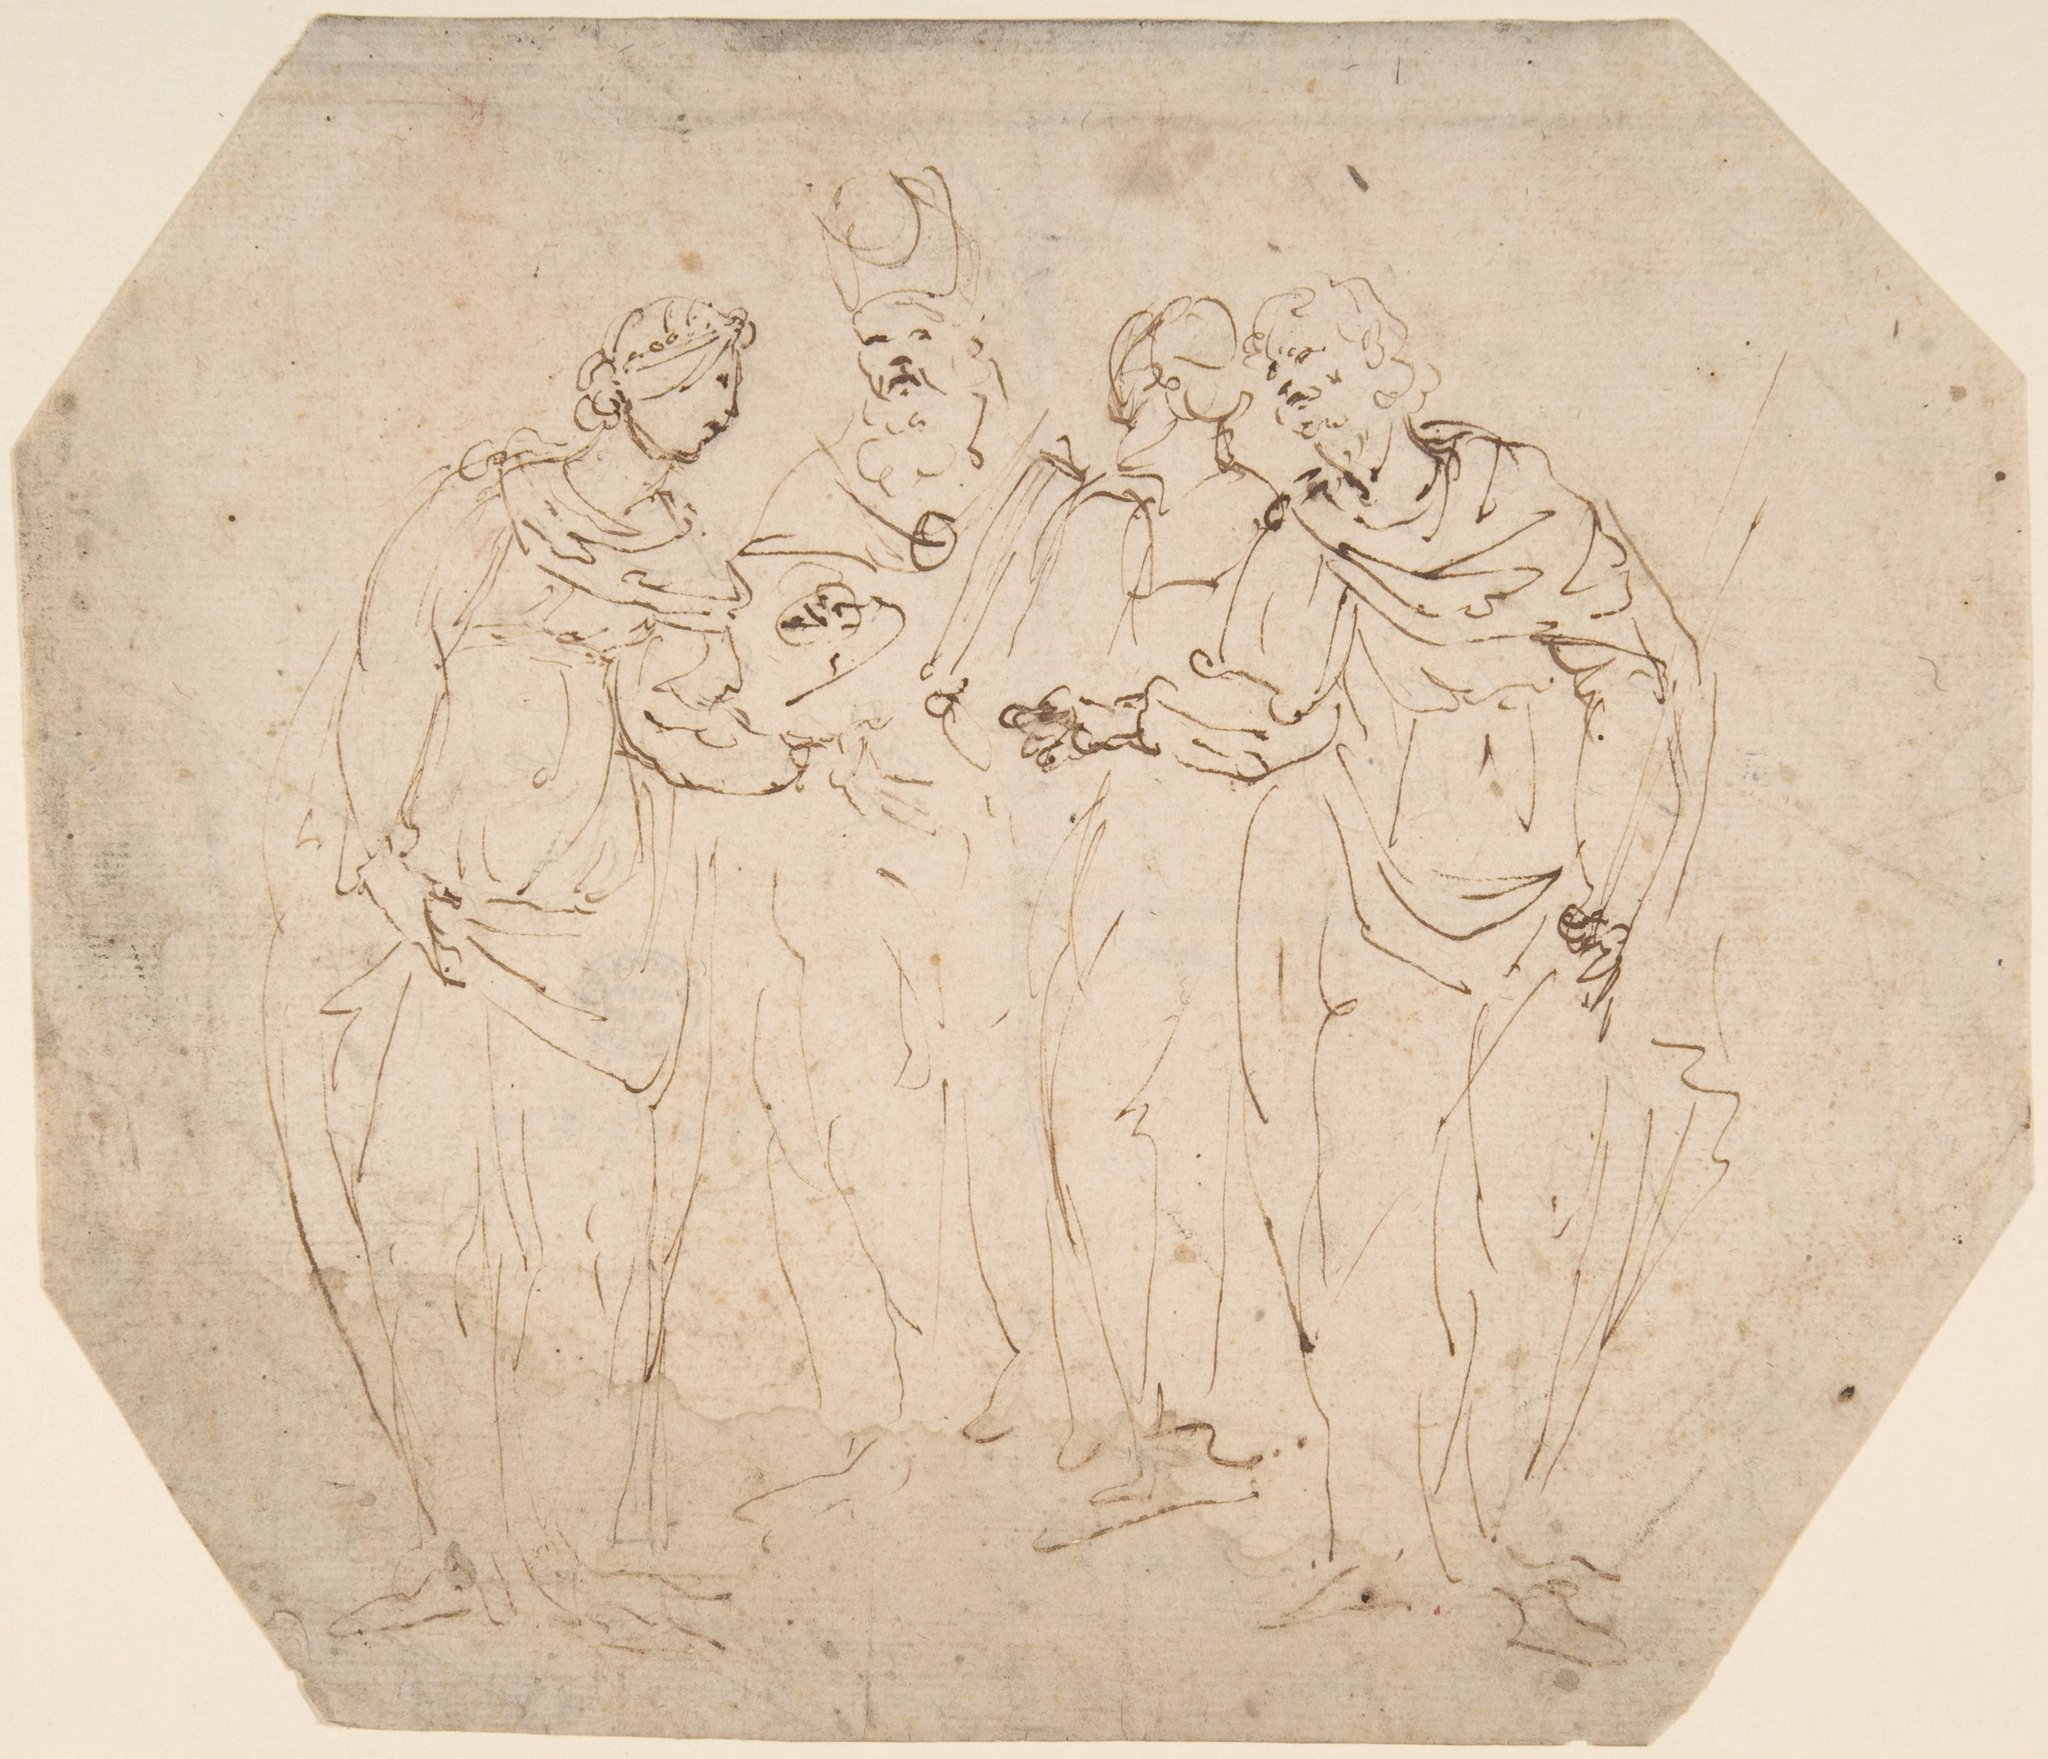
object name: drawing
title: Meeting of Four Figures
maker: anonymous, italian, 17th century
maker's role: artist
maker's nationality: italian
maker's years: 1600-1700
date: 1601-1700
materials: ink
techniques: pen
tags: men